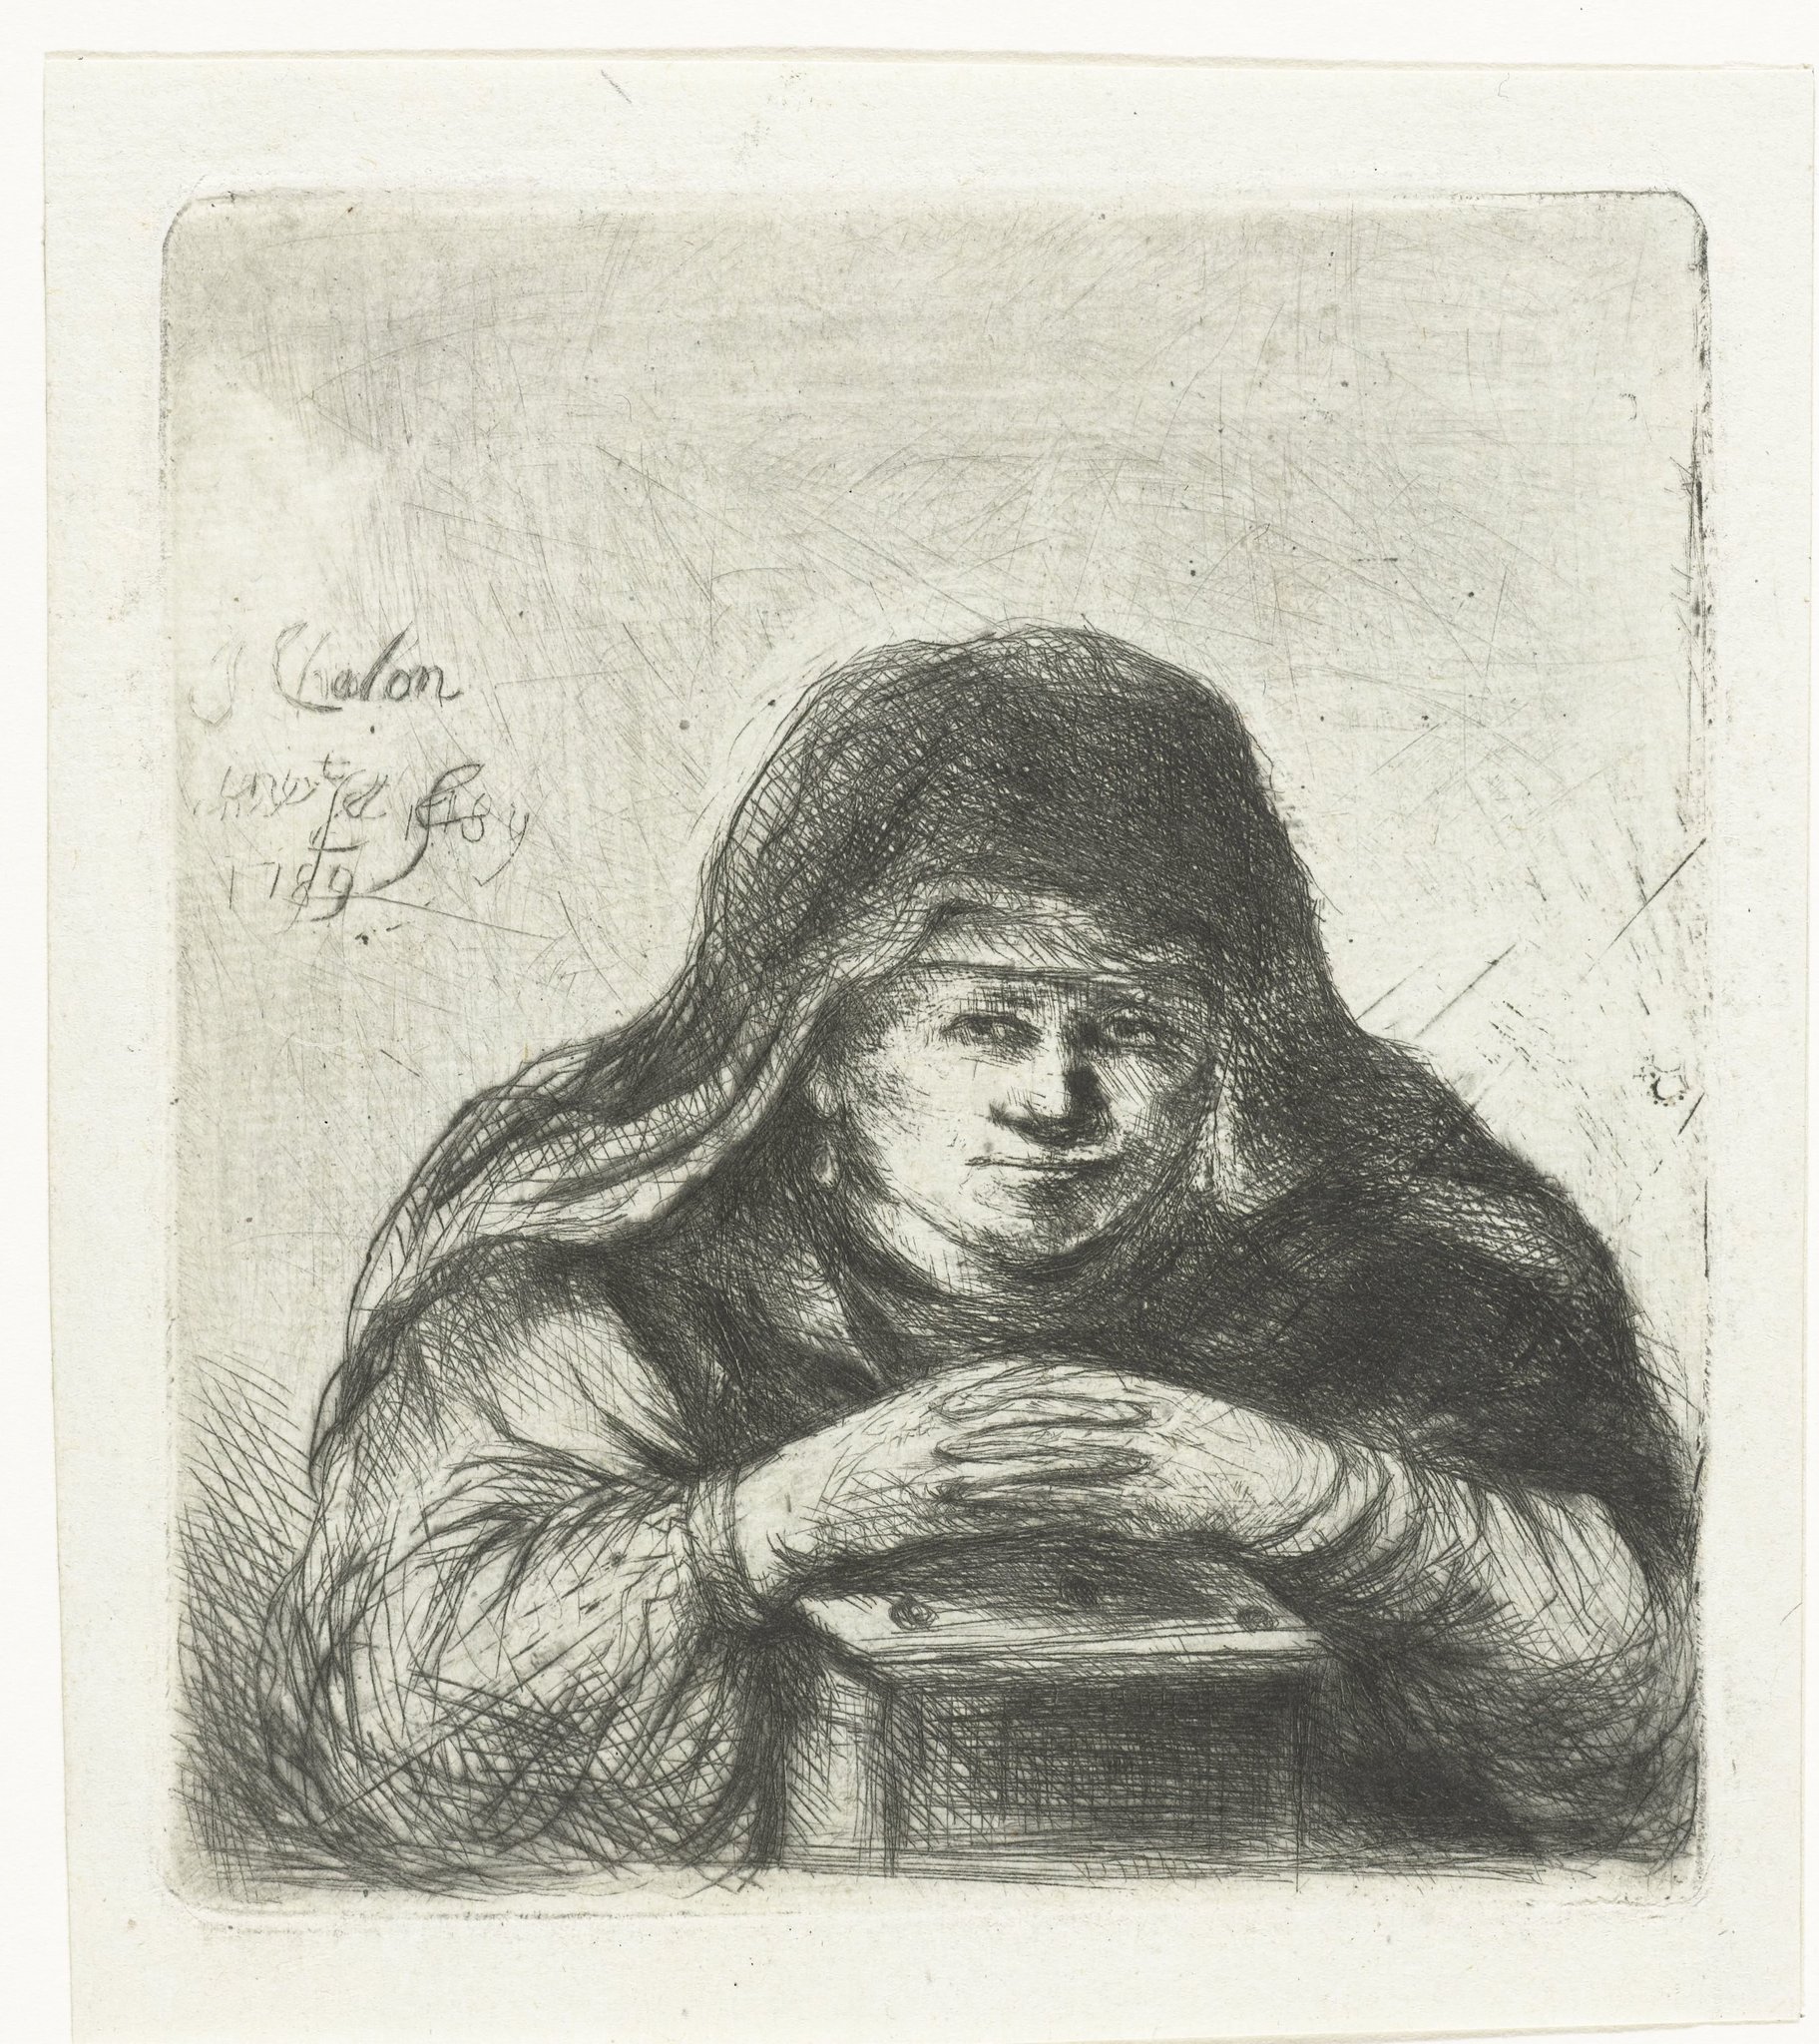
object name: print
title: Oude vrouw boven een stoof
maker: jan chalon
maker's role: print maker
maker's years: 1738-1795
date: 1789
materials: paper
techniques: drypoint, etching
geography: northern netherlands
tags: head-gear, heating stove, morphology of human expression (+ adult female (human being))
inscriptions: collector's mark: Lugt 2228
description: Een onbekende vrouw met sluier warmt zich boven een stoof.